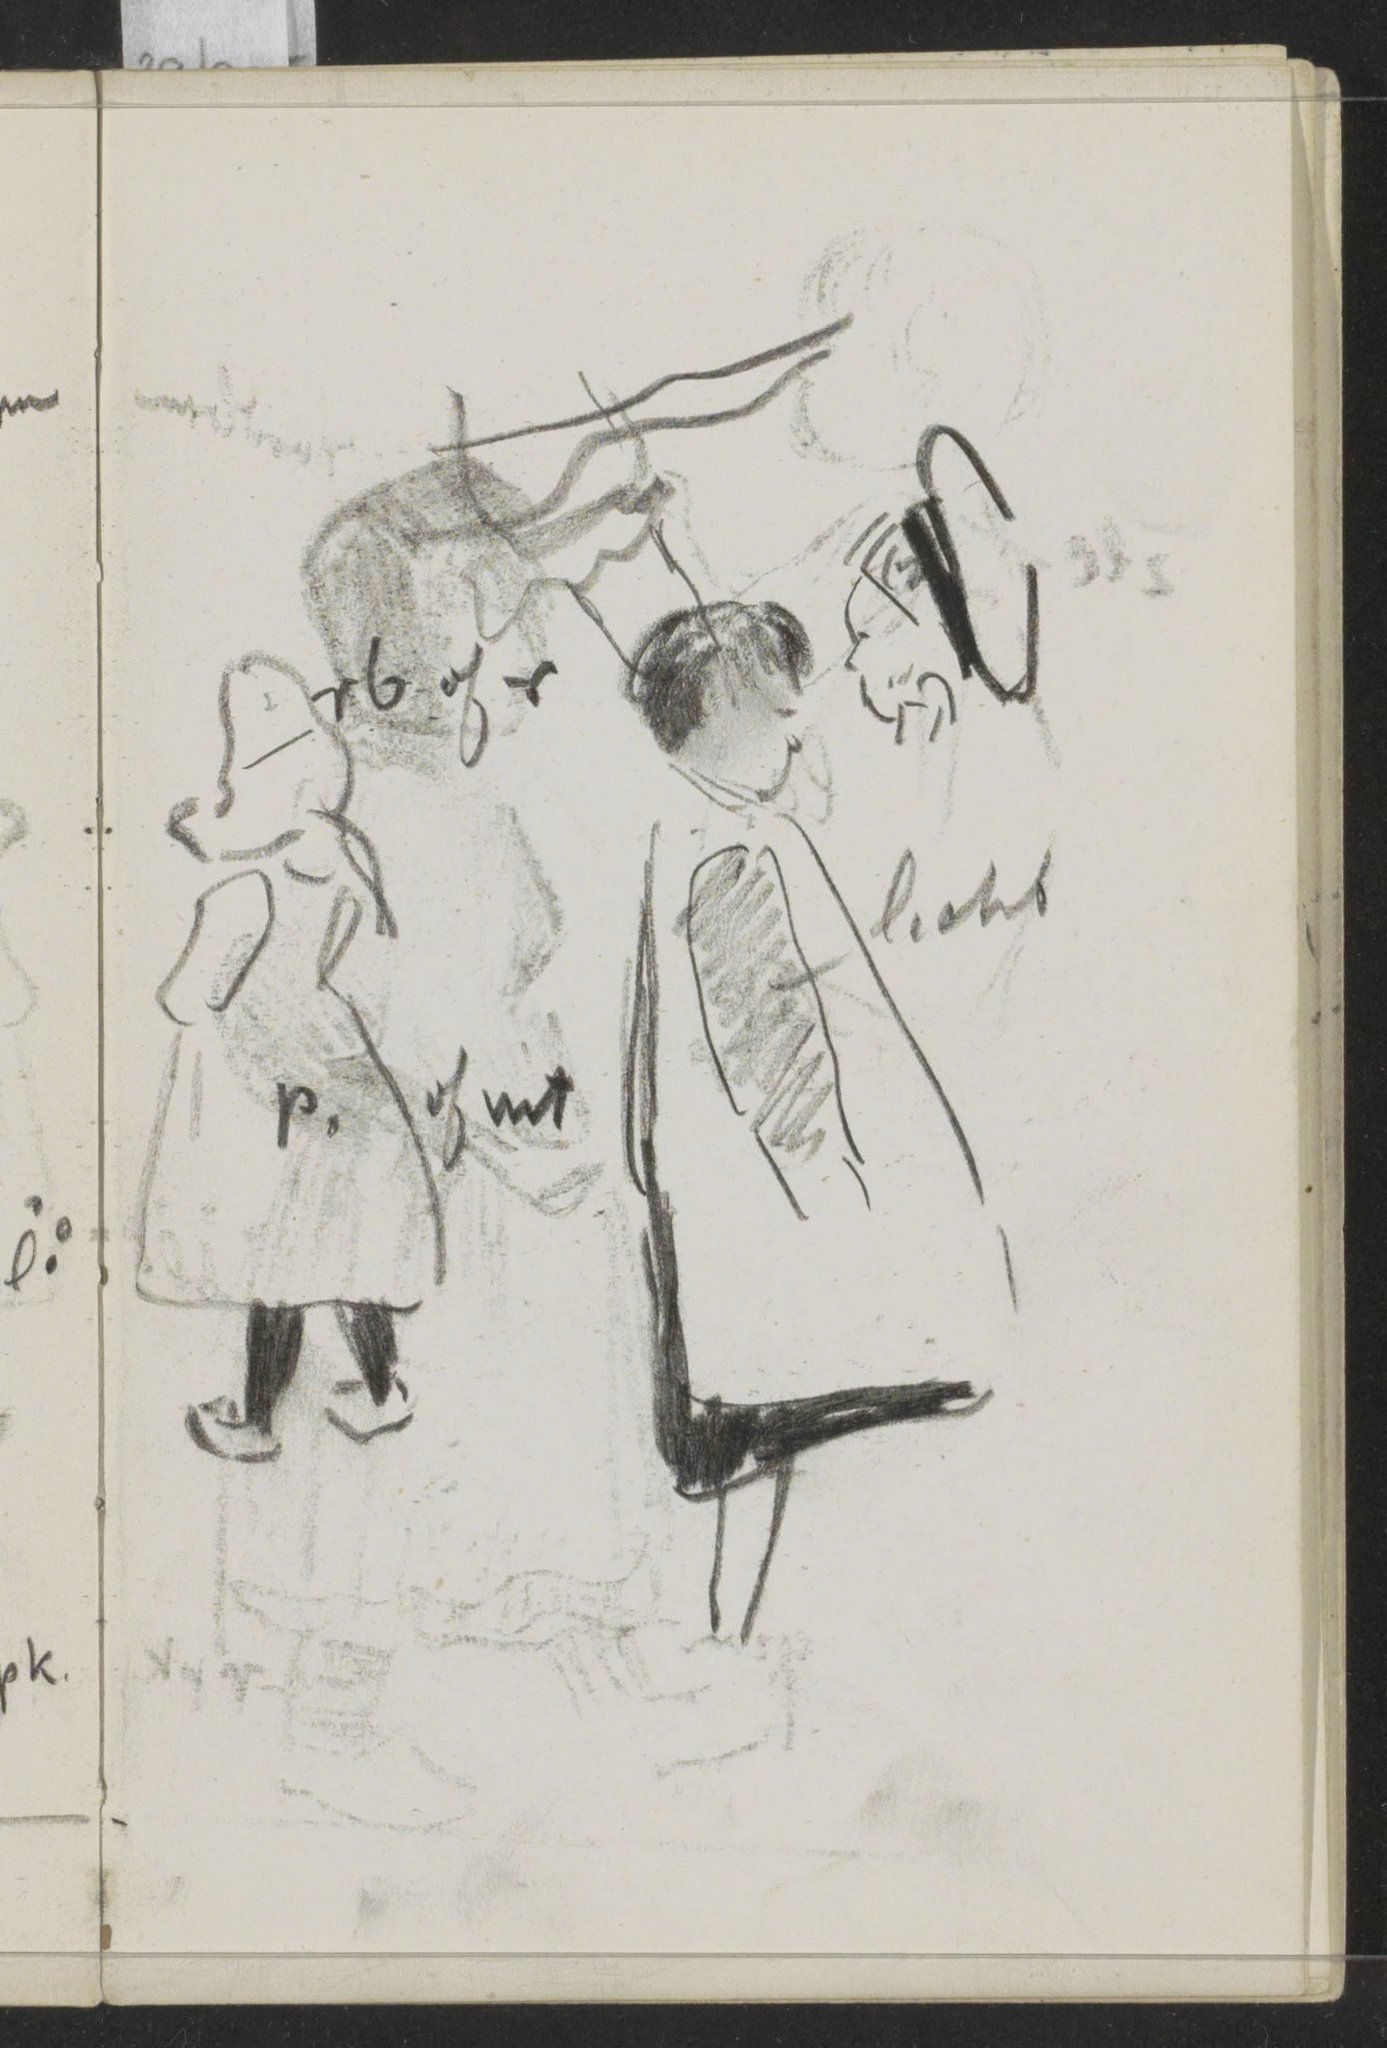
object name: sketchbook leaf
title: Kinderen in klederdracht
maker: carel adolph lion cachet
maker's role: draughtsman, print maker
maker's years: 1864-1945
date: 1874-1945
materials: chalk, paper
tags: child, folk costume, regional costume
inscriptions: kleurnotitie, handgeschreven in zwart krijt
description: Blad 26 recto uit een schetsboek met 41 bladen.